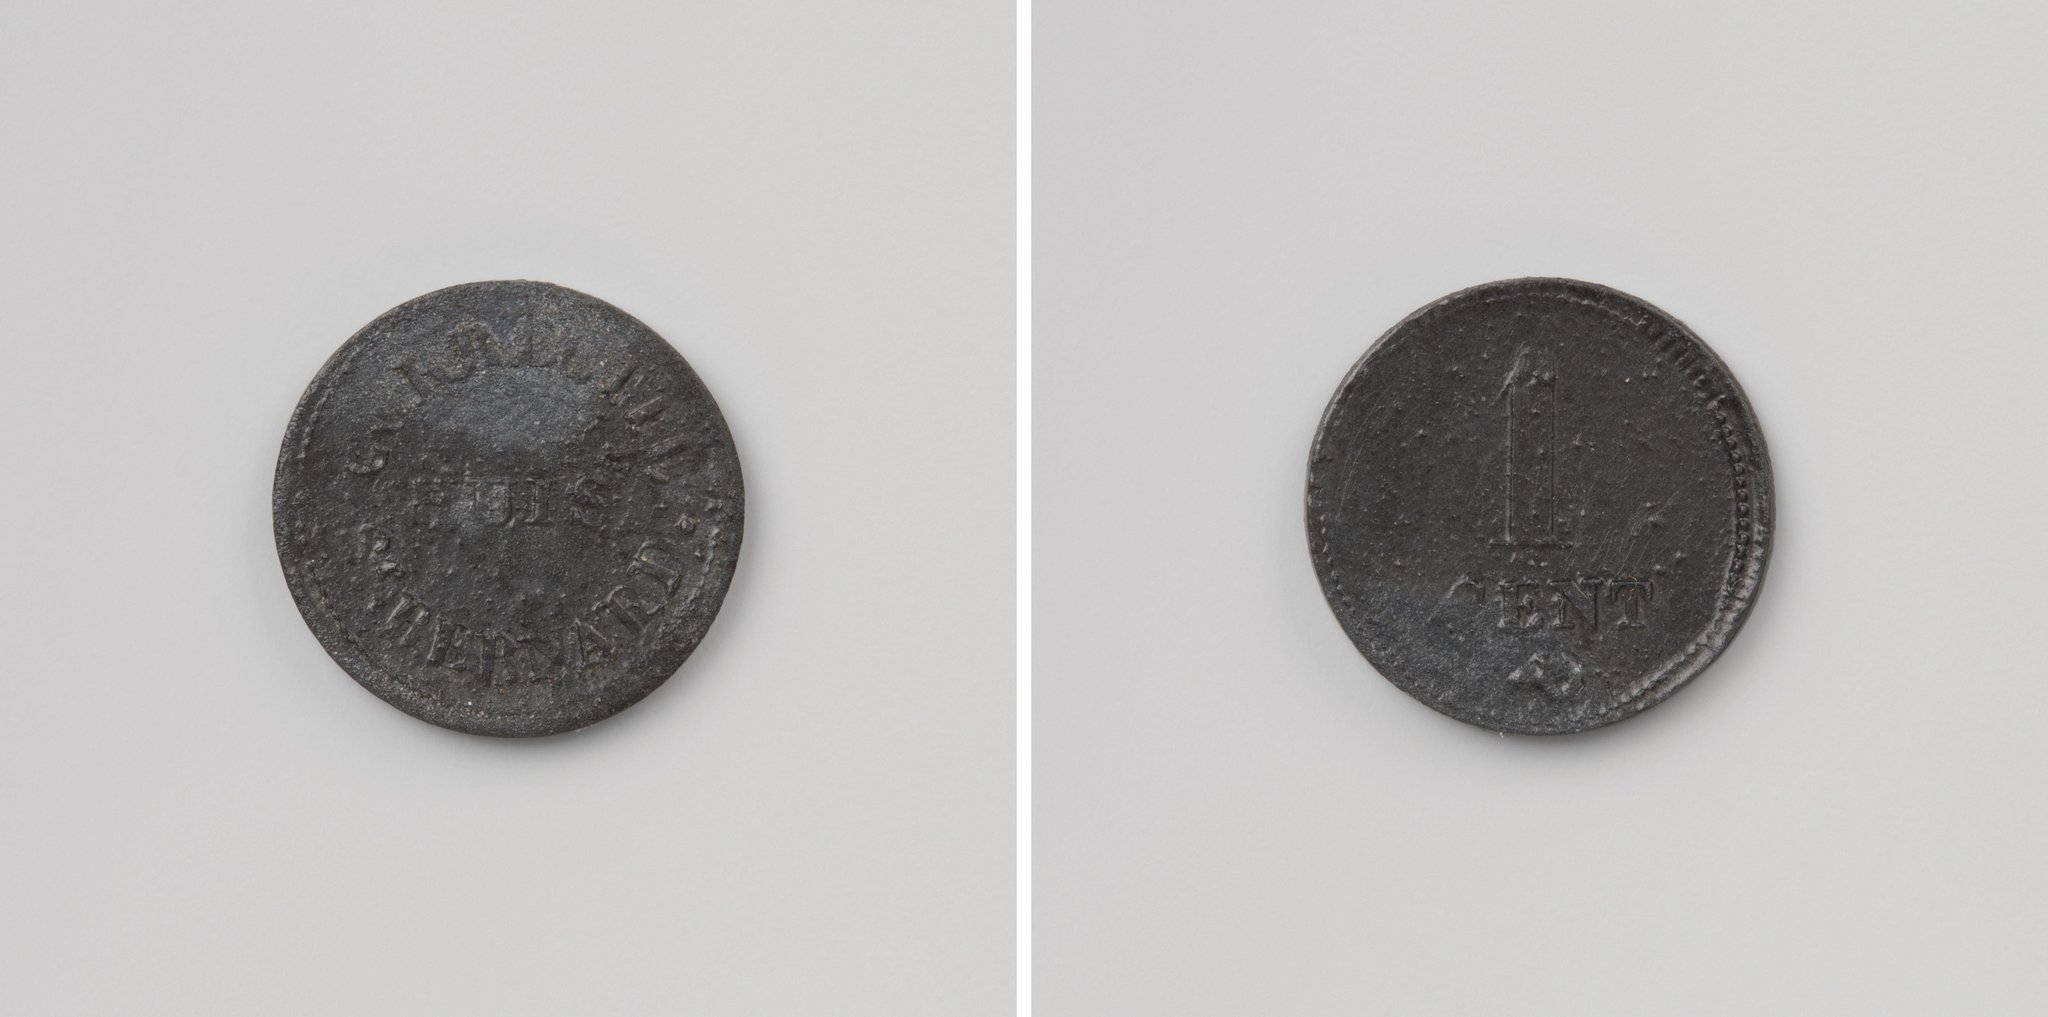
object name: huismunt prison money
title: Correctiehuis Sint Bernhard te Hemiksem, huismunt ter waarde van een cent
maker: joseph pierre braemt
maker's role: print maker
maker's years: 1796-1864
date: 1826-1833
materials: zinc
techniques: striking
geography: brussels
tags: ghent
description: Zinken betaalpenning. Voorzijde: opschrift binnen omschrift. Keerzijde: waardeaanduiding